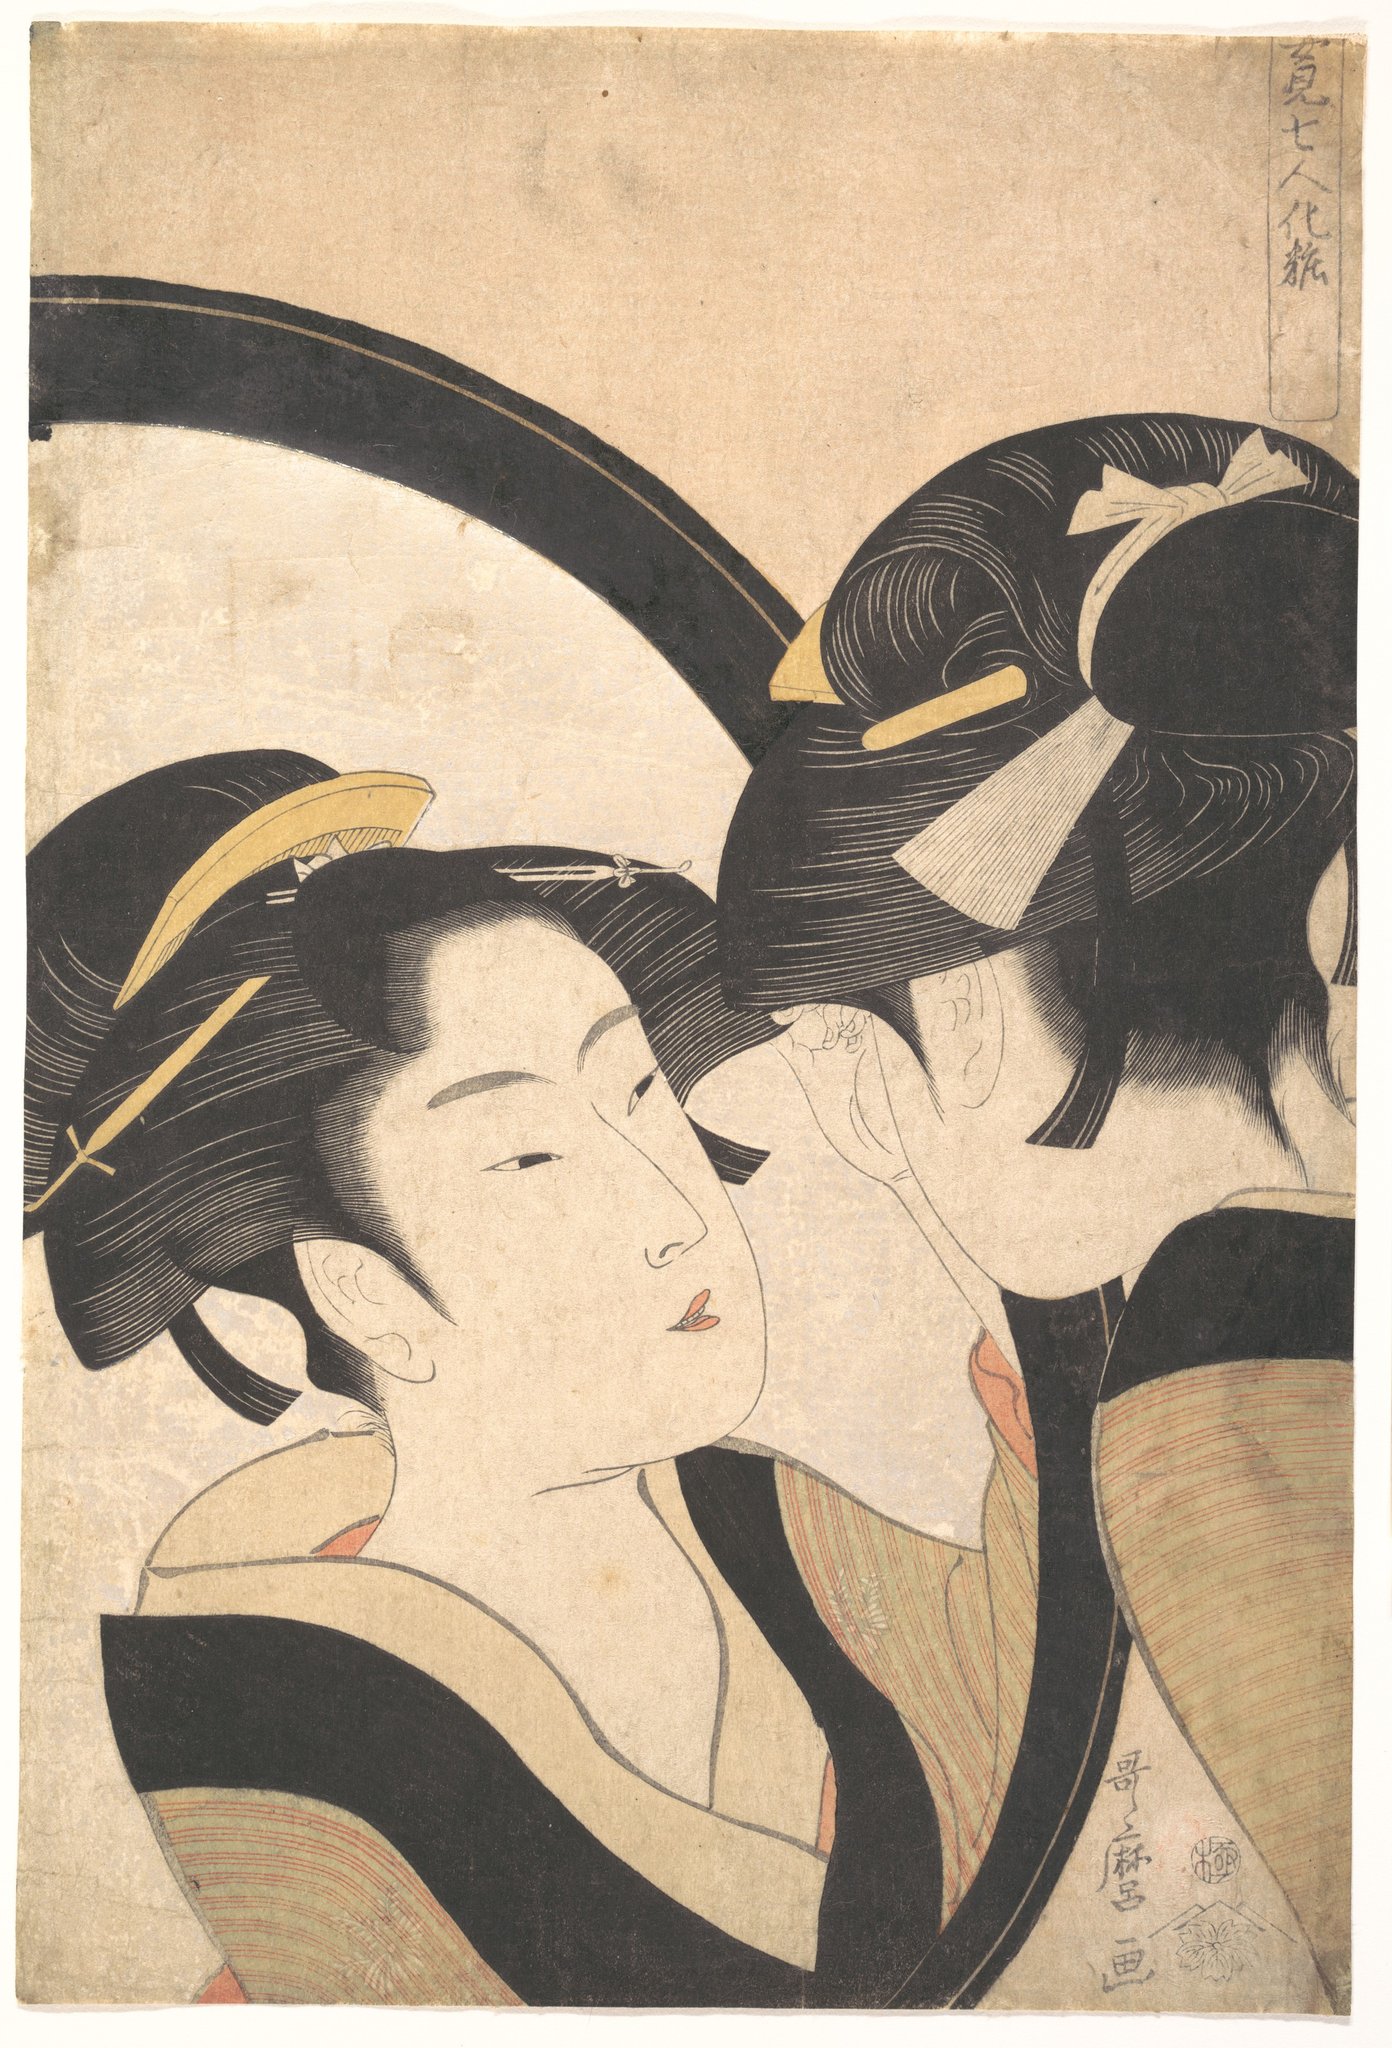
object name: print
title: Naniwa Okita Admiring Herself in a Mirror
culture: japanese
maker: kitagawa utamaro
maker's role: artist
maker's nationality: japanese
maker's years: 1754-1806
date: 1790-1795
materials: ink, mica, paper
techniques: woodblock print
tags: women,mirrors